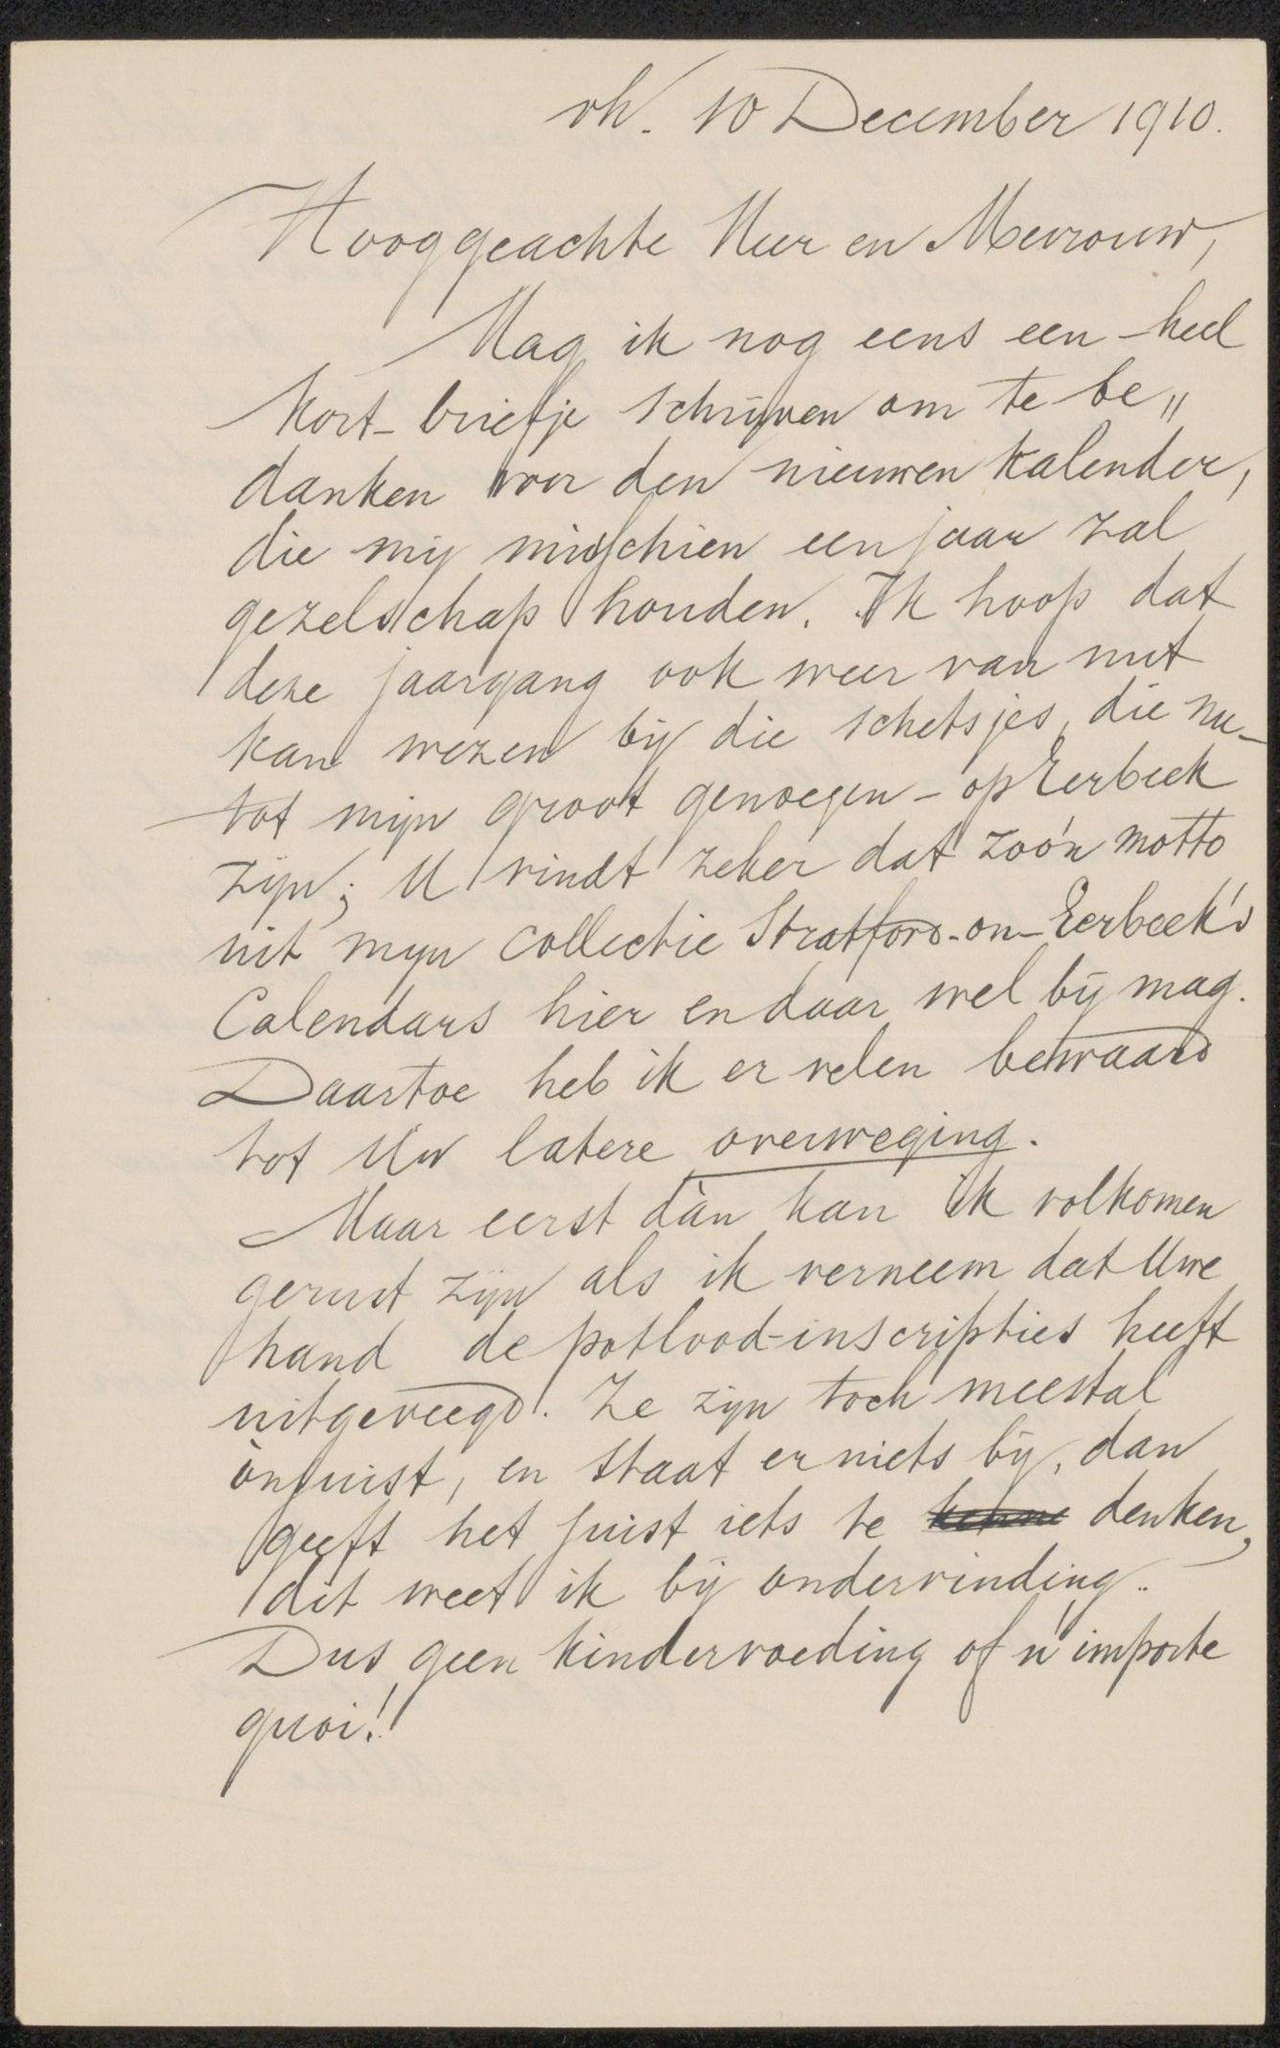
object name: letter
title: Brief aan Anne Antoinette Weber-Van Bosse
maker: august allebé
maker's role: draughtsman, print maker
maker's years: 1838-1927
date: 1910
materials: ink, paper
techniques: pen, writing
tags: amsterdam, anne antoinette weber-van bosse, drawing